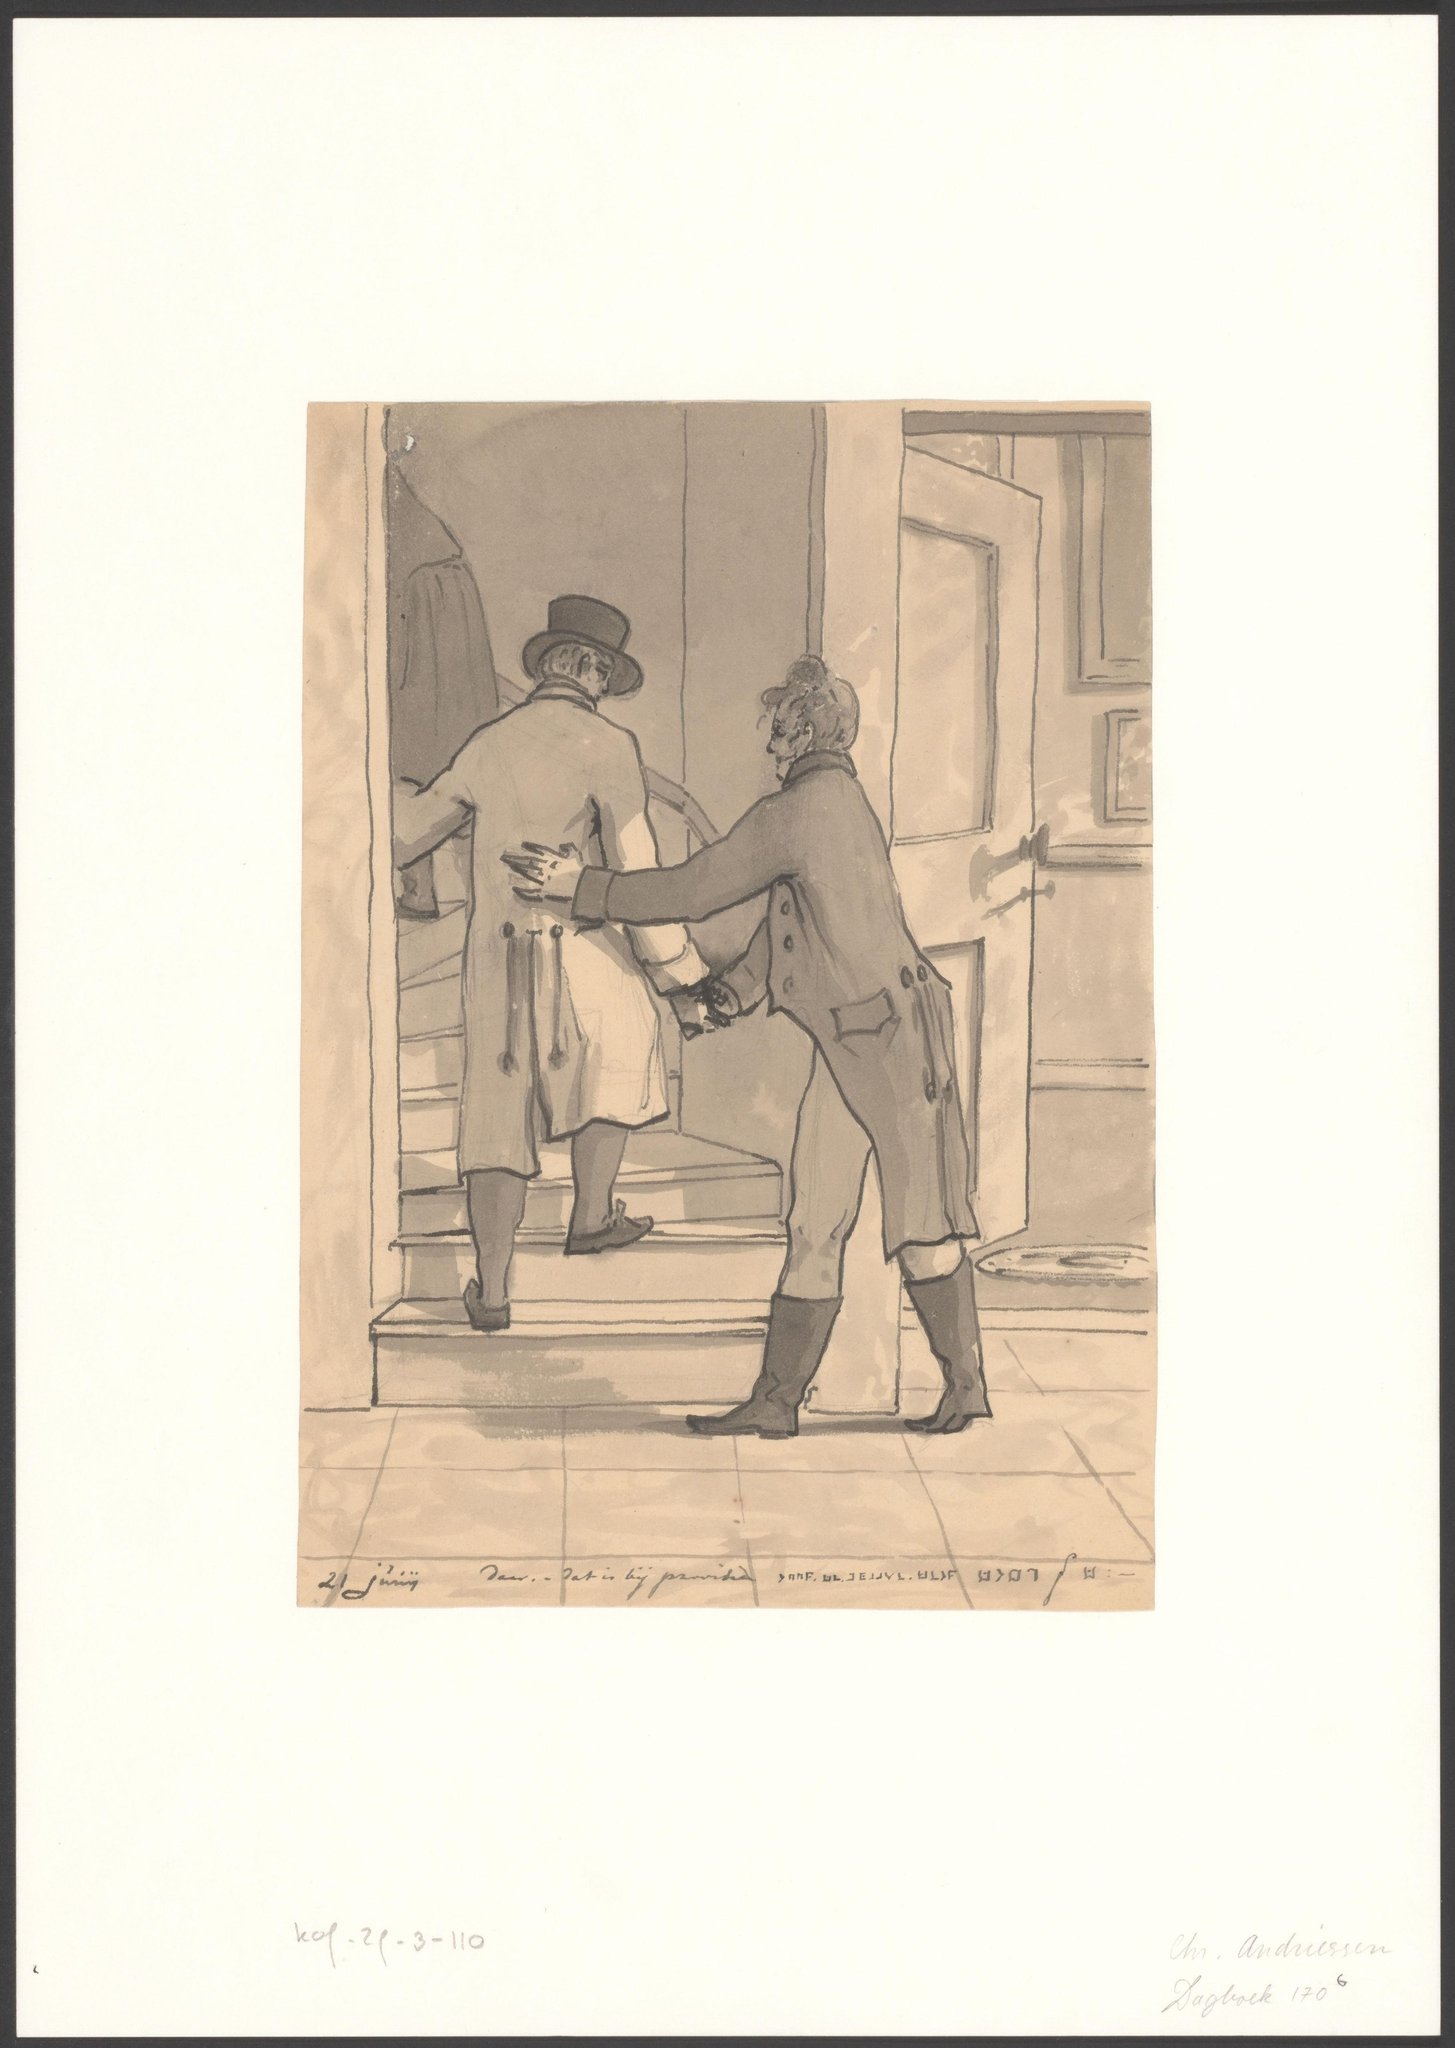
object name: drawing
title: Christiaan Andriessen geeft provisie aan een man die de trap op loopt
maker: christiaan andriessen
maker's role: draughtsman, print maker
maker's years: 1775-1846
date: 1805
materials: ink, paper, pencil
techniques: brush, pen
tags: amsterdam, print maker, draughtsman, christiaan andriessen, staircase, head-gear: top hat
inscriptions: inscription: ‘21 junij daar dat is bij provisie’, signature: ‘J Andriessen’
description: Dagboekblad uit het getekende dagboek dat Christiaan Andriessen bijhield van 1805 tot en met 1808.